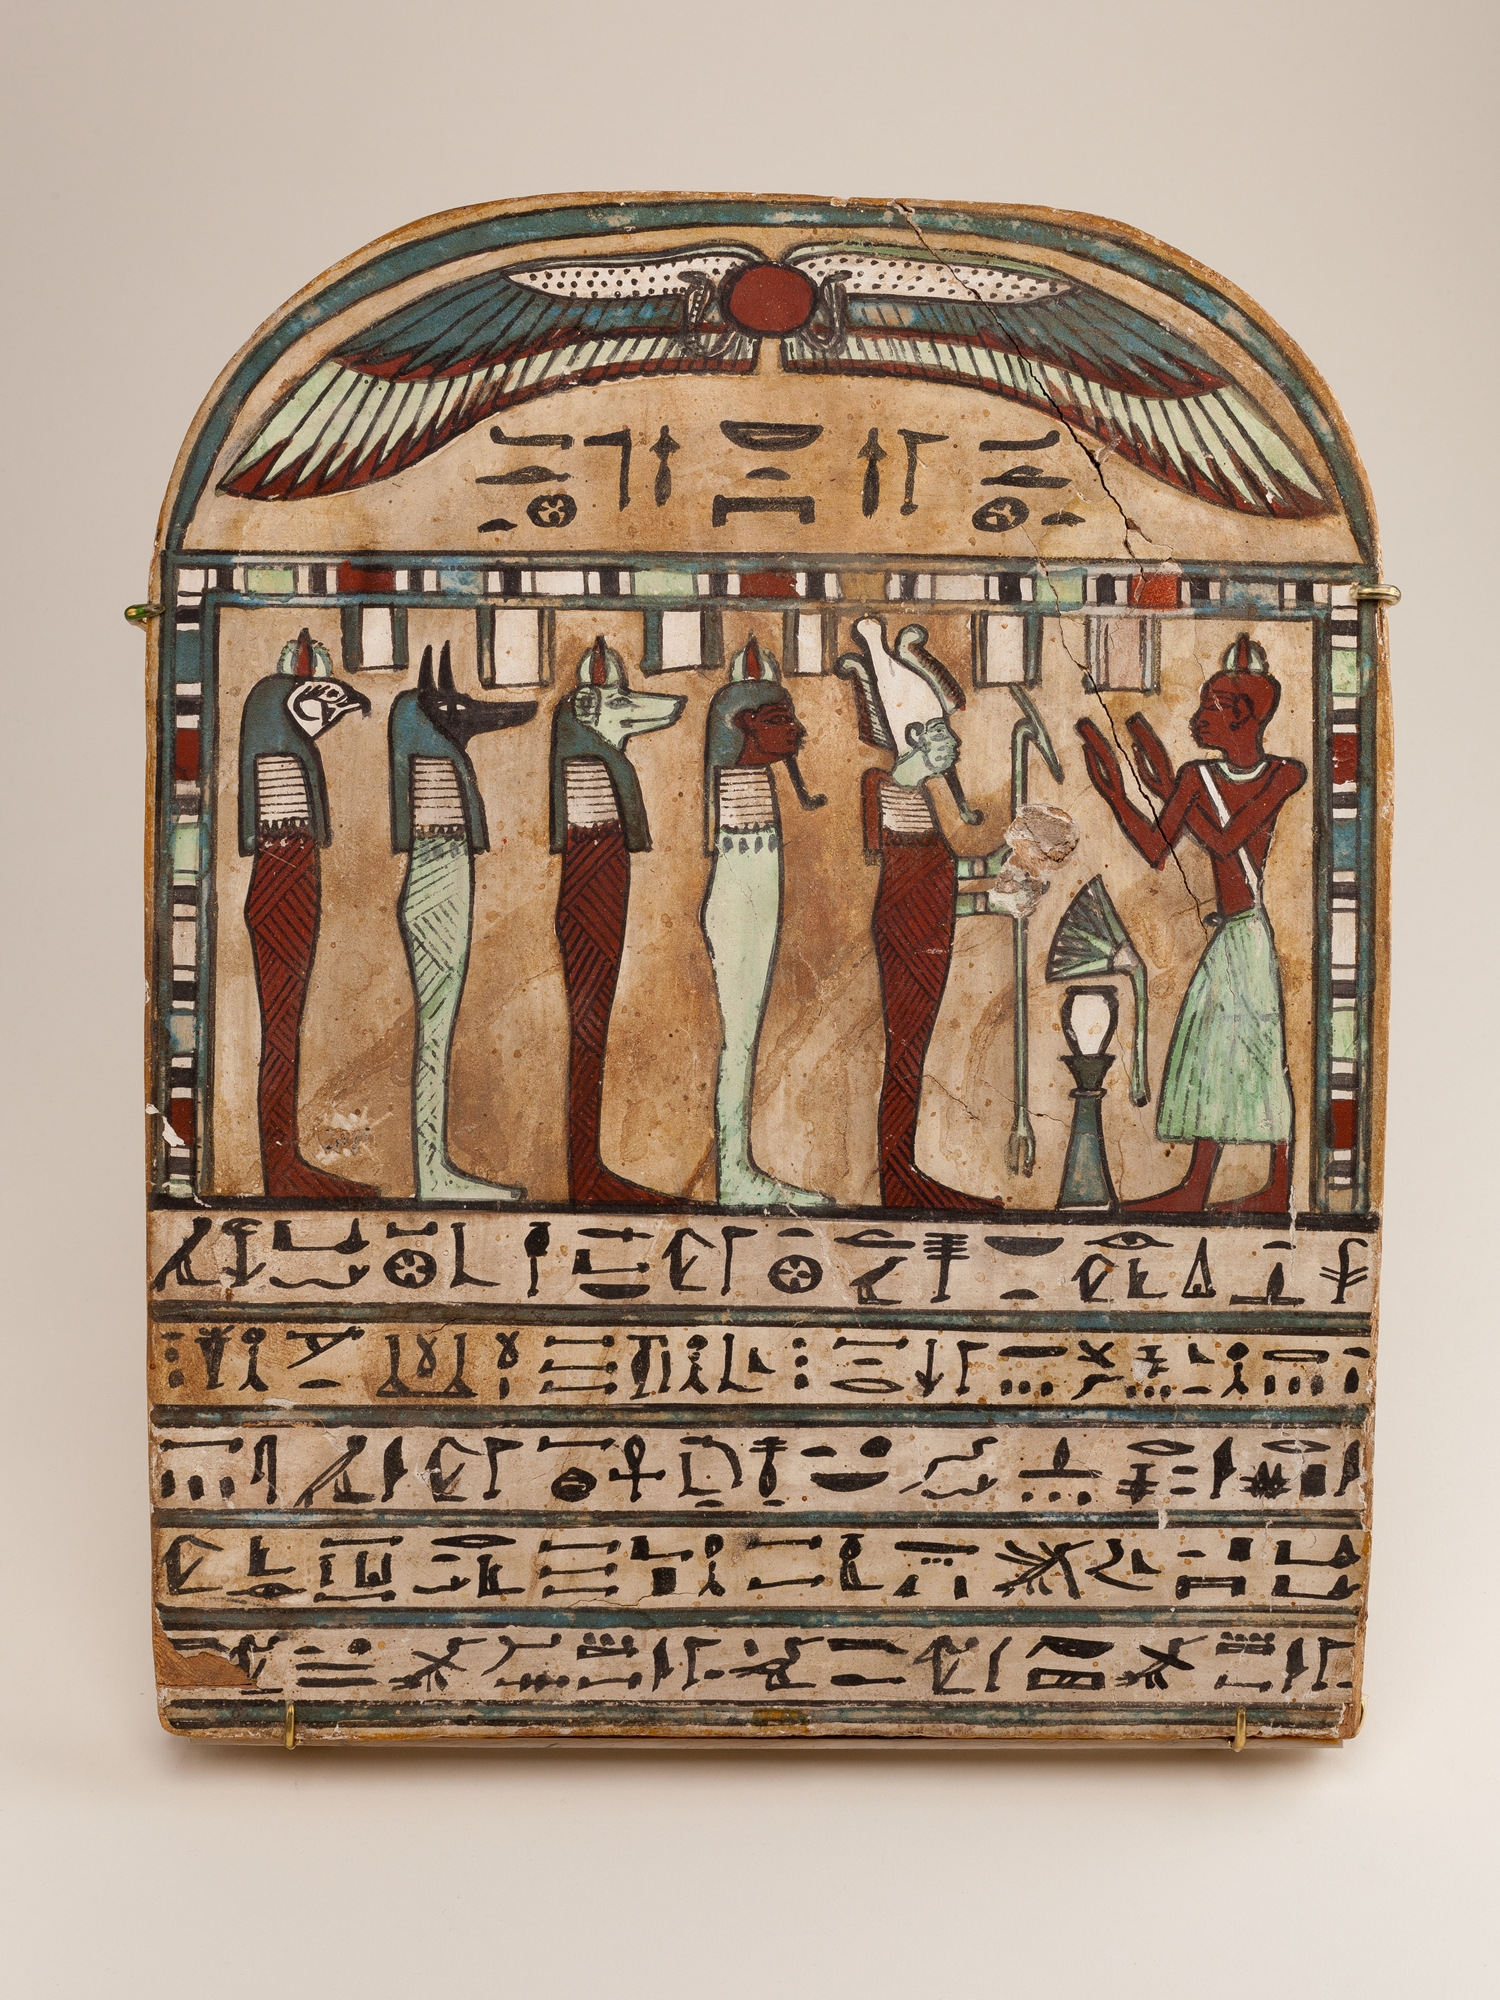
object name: stela, amun, pakeshi, nespautitawi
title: Stela of the God's-Father of Amun Pakeshi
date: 750-525 BCE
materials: gesso, paint, wood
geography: egypt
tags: hieroglyphs,amun